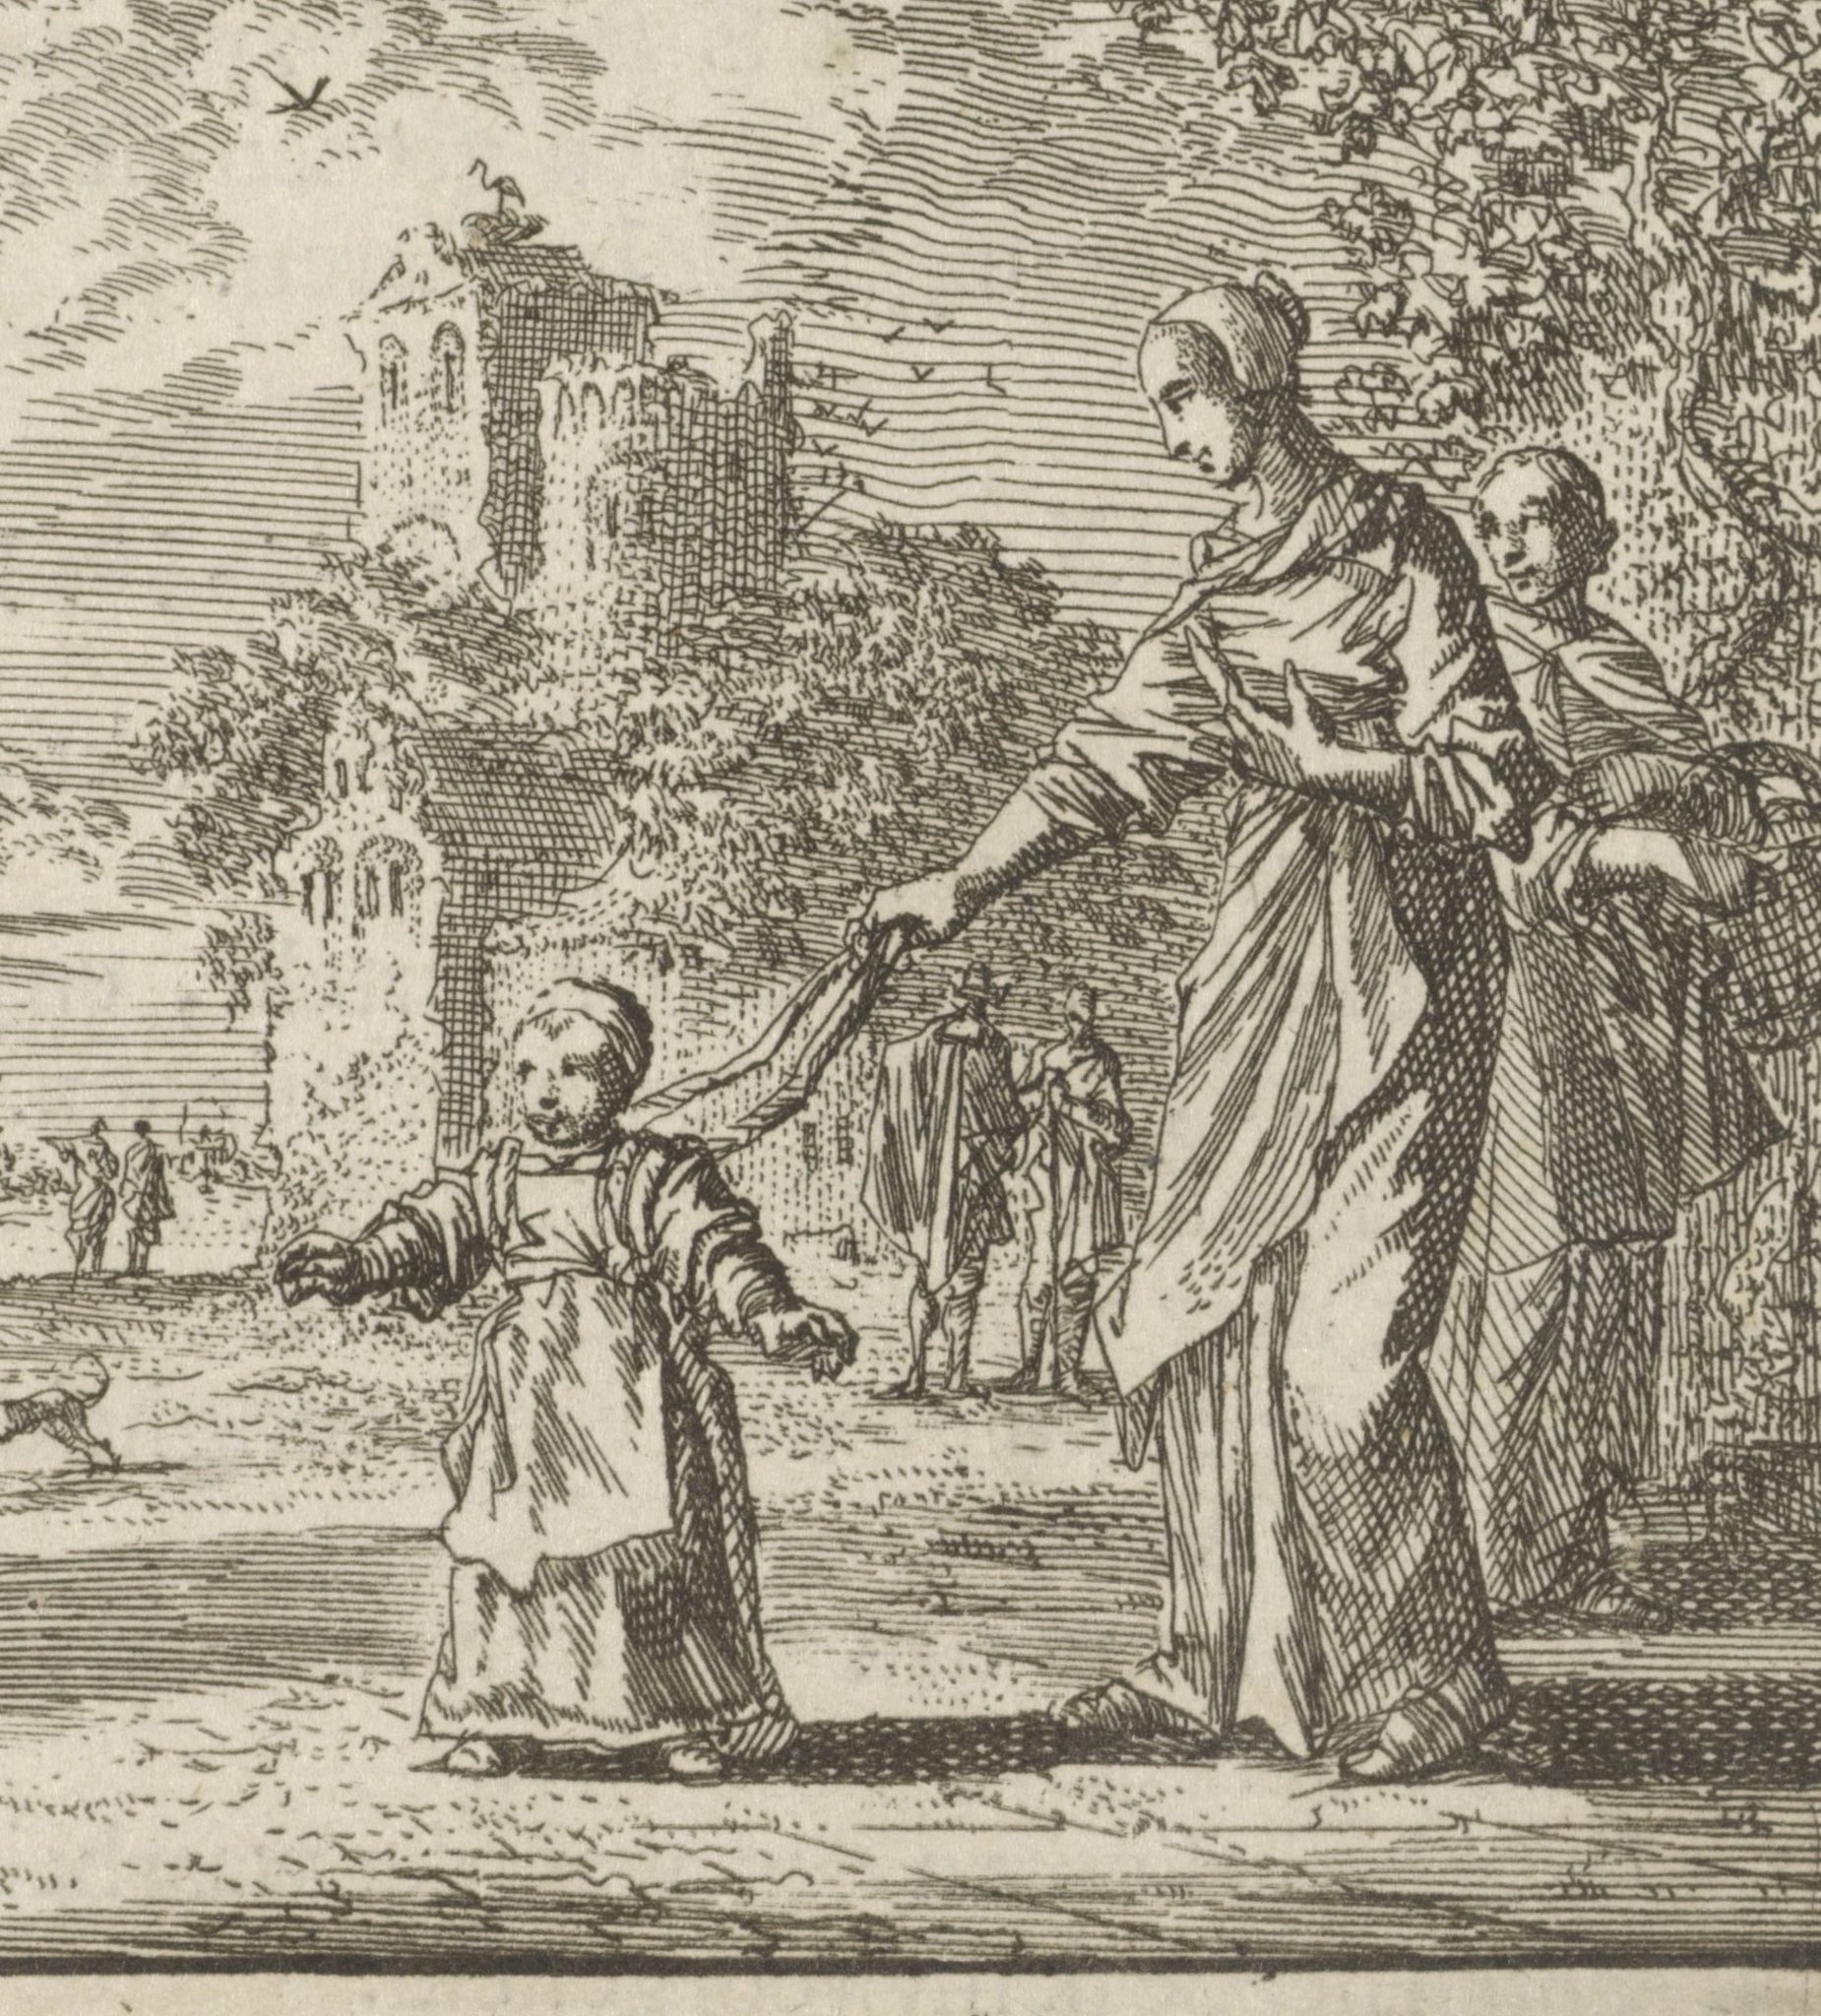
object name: print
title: Moeder leert kind aan een leiband lopen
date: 1712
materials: paper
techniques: etching, letterpress printing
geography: amsterdam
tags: mother and baby or young child, learning to walk, the first steps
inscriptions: collector's mark: Lugt 2228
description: Illustratie uit: Luyken, Jan. Des menschen begin, midden en einde. Amsterdam: Wed. Pieter Arentsz II en Cornelis van der Sys, 1712, p. 11.